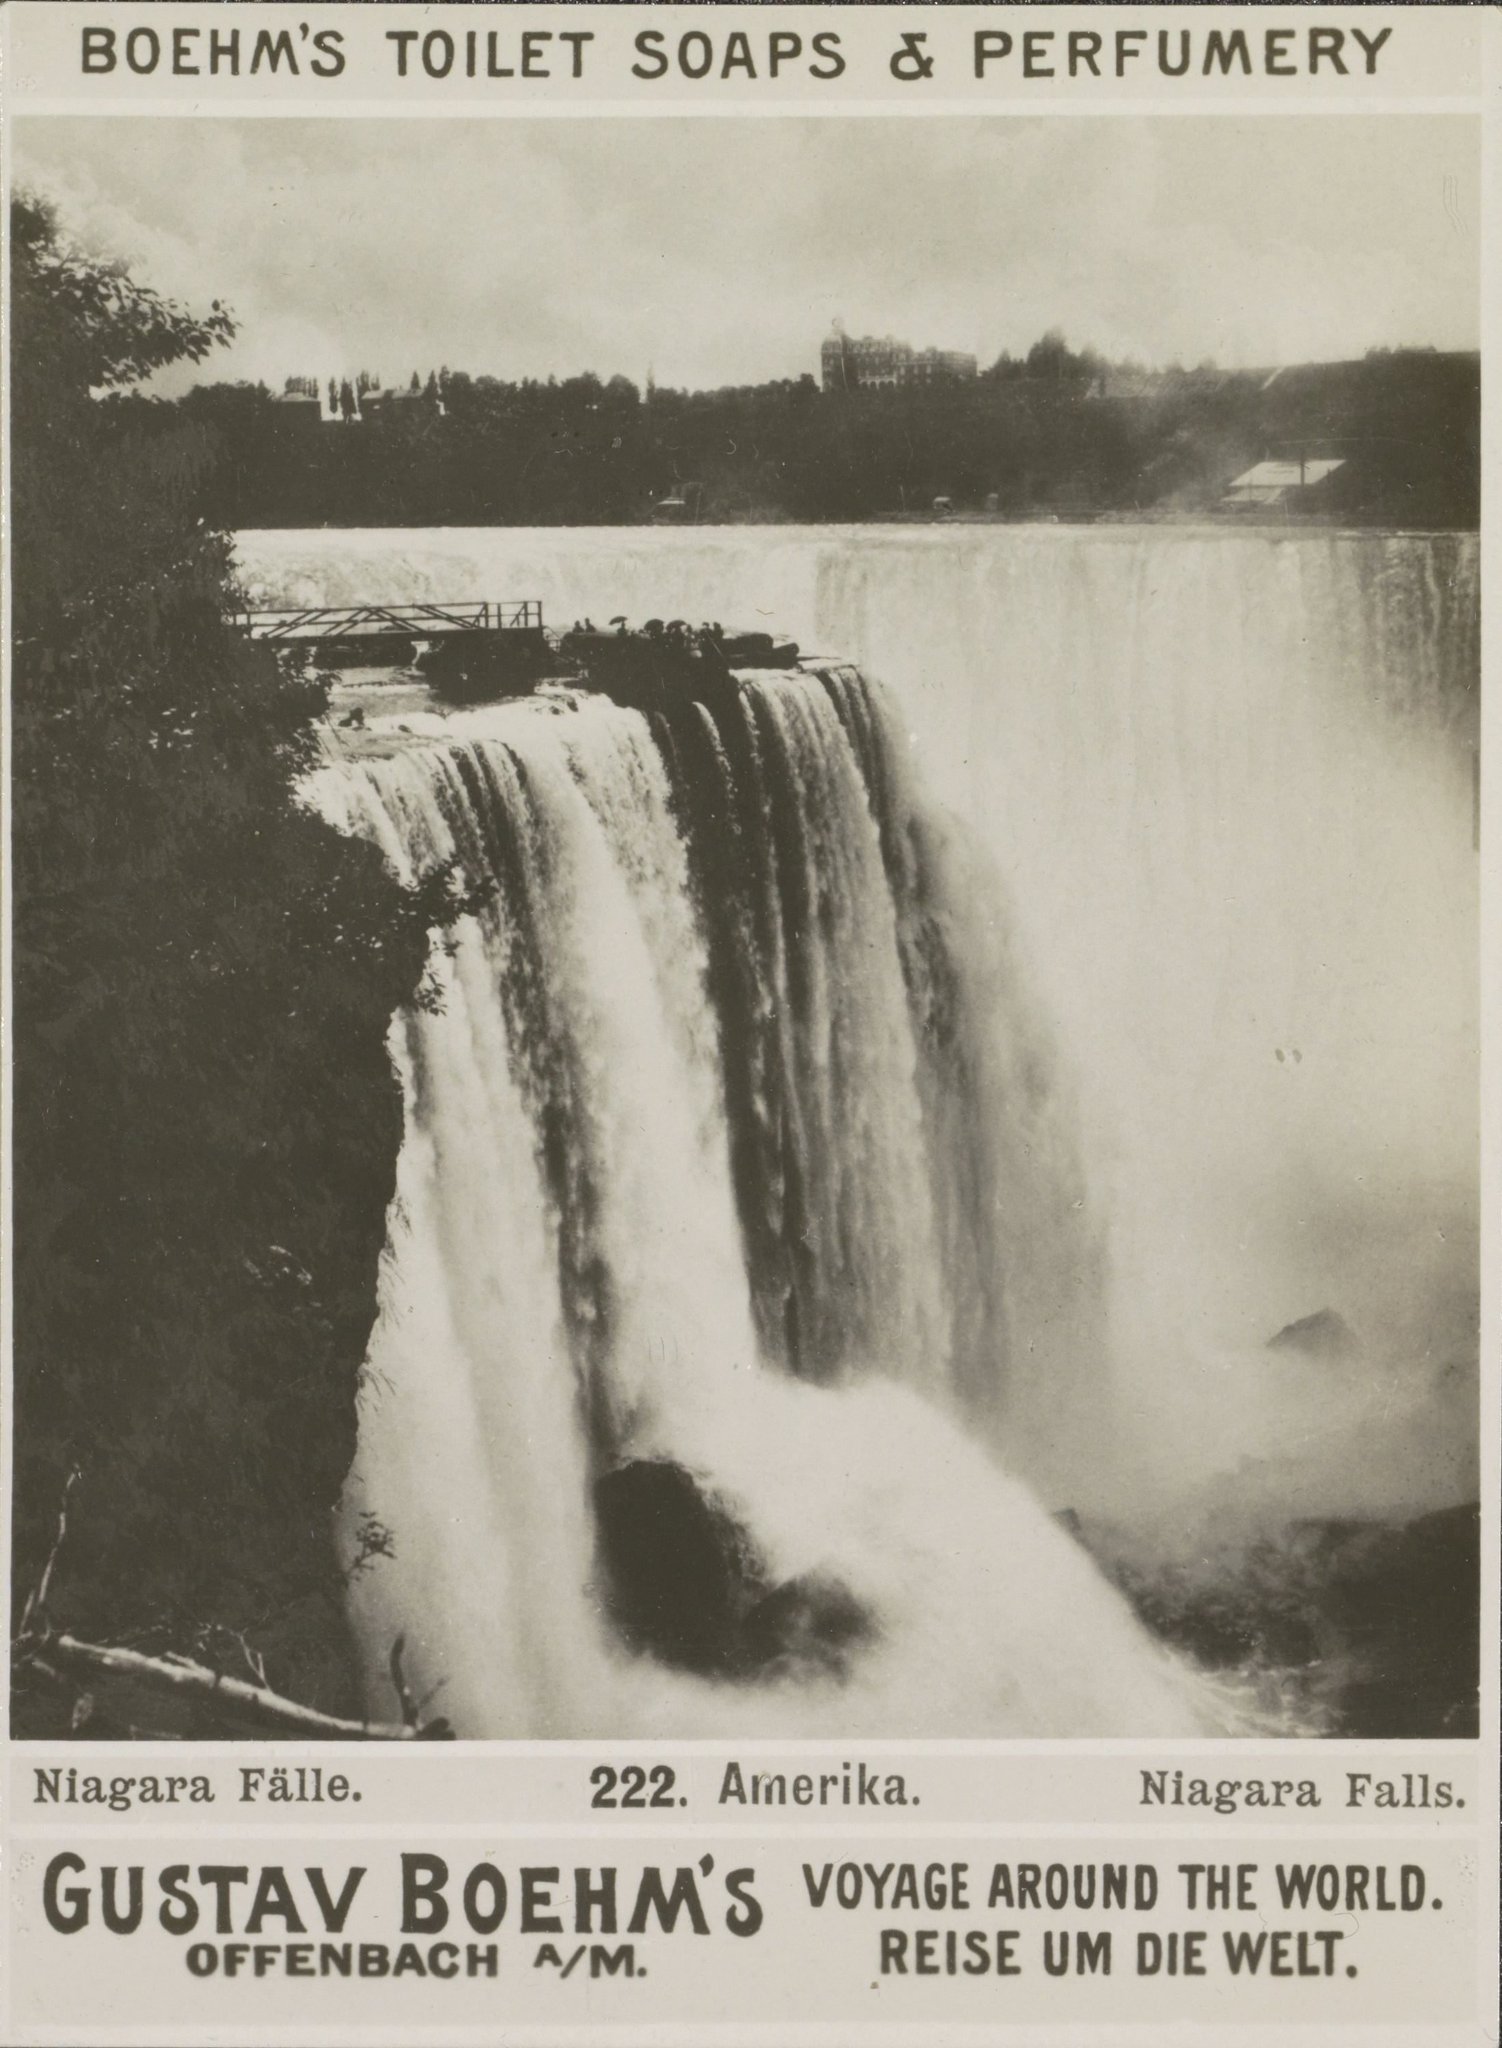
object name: photograph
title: Gezicht op de Niagarawatervallen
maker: h.f. nielson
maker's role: fotograaf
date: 1899-1901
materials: paper, photographic support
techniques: gelatin silver print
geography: niagara falls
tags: waterfall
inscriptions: number: ‘222’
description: Onderdeel van Foto's van de wereldreis van Gustav Boehm 1899-1901, serie 2.